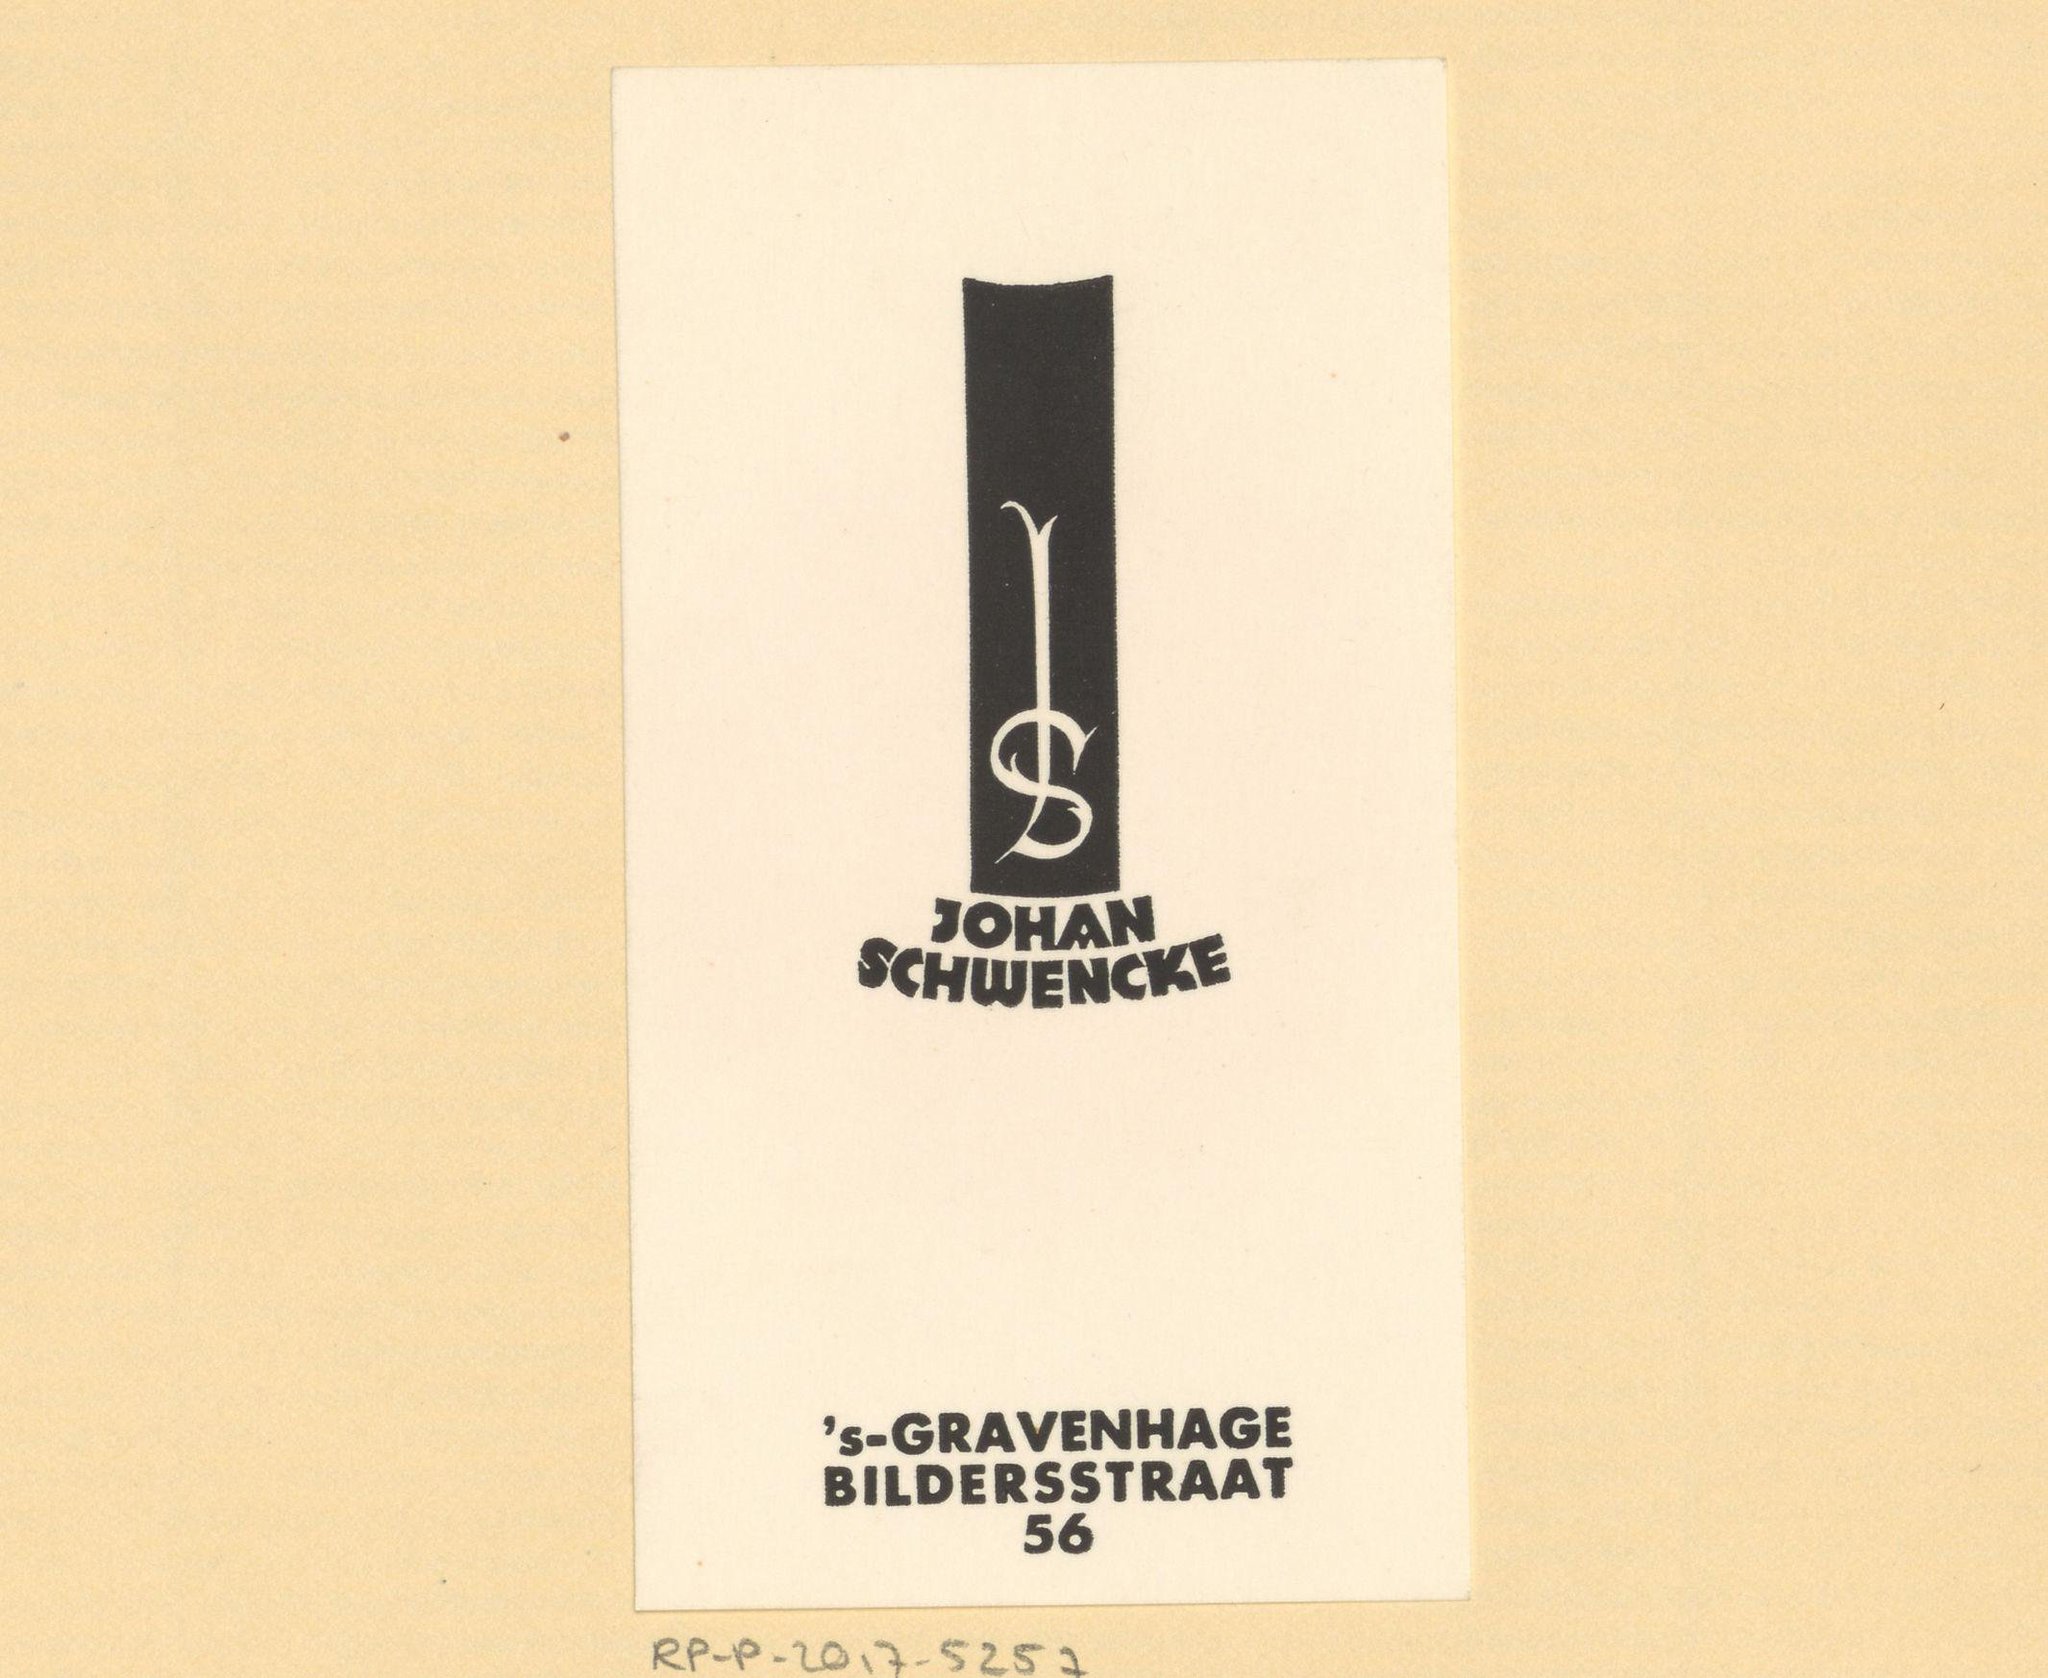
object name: bookplate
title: Ex libris van Johan Schwencke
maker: Anonymous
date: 1934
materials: paper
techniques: printing block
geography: austria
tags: the hague, johannes jacobus schwencke (johan)